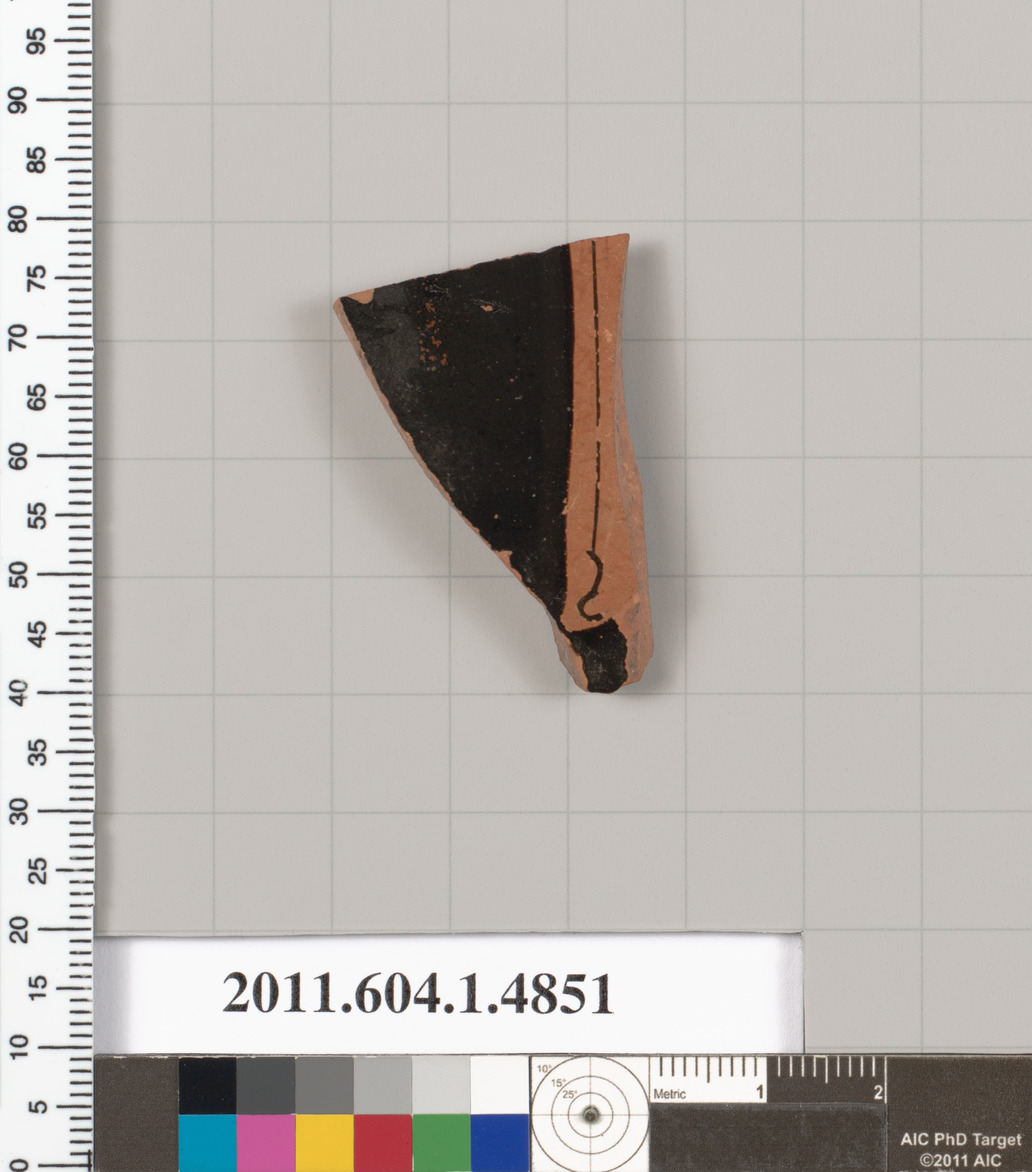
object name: kylix fragment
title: Terracotta fragment of a kylix (drinking cup)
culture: greek, attic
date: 500-480 BCE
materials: terracotta